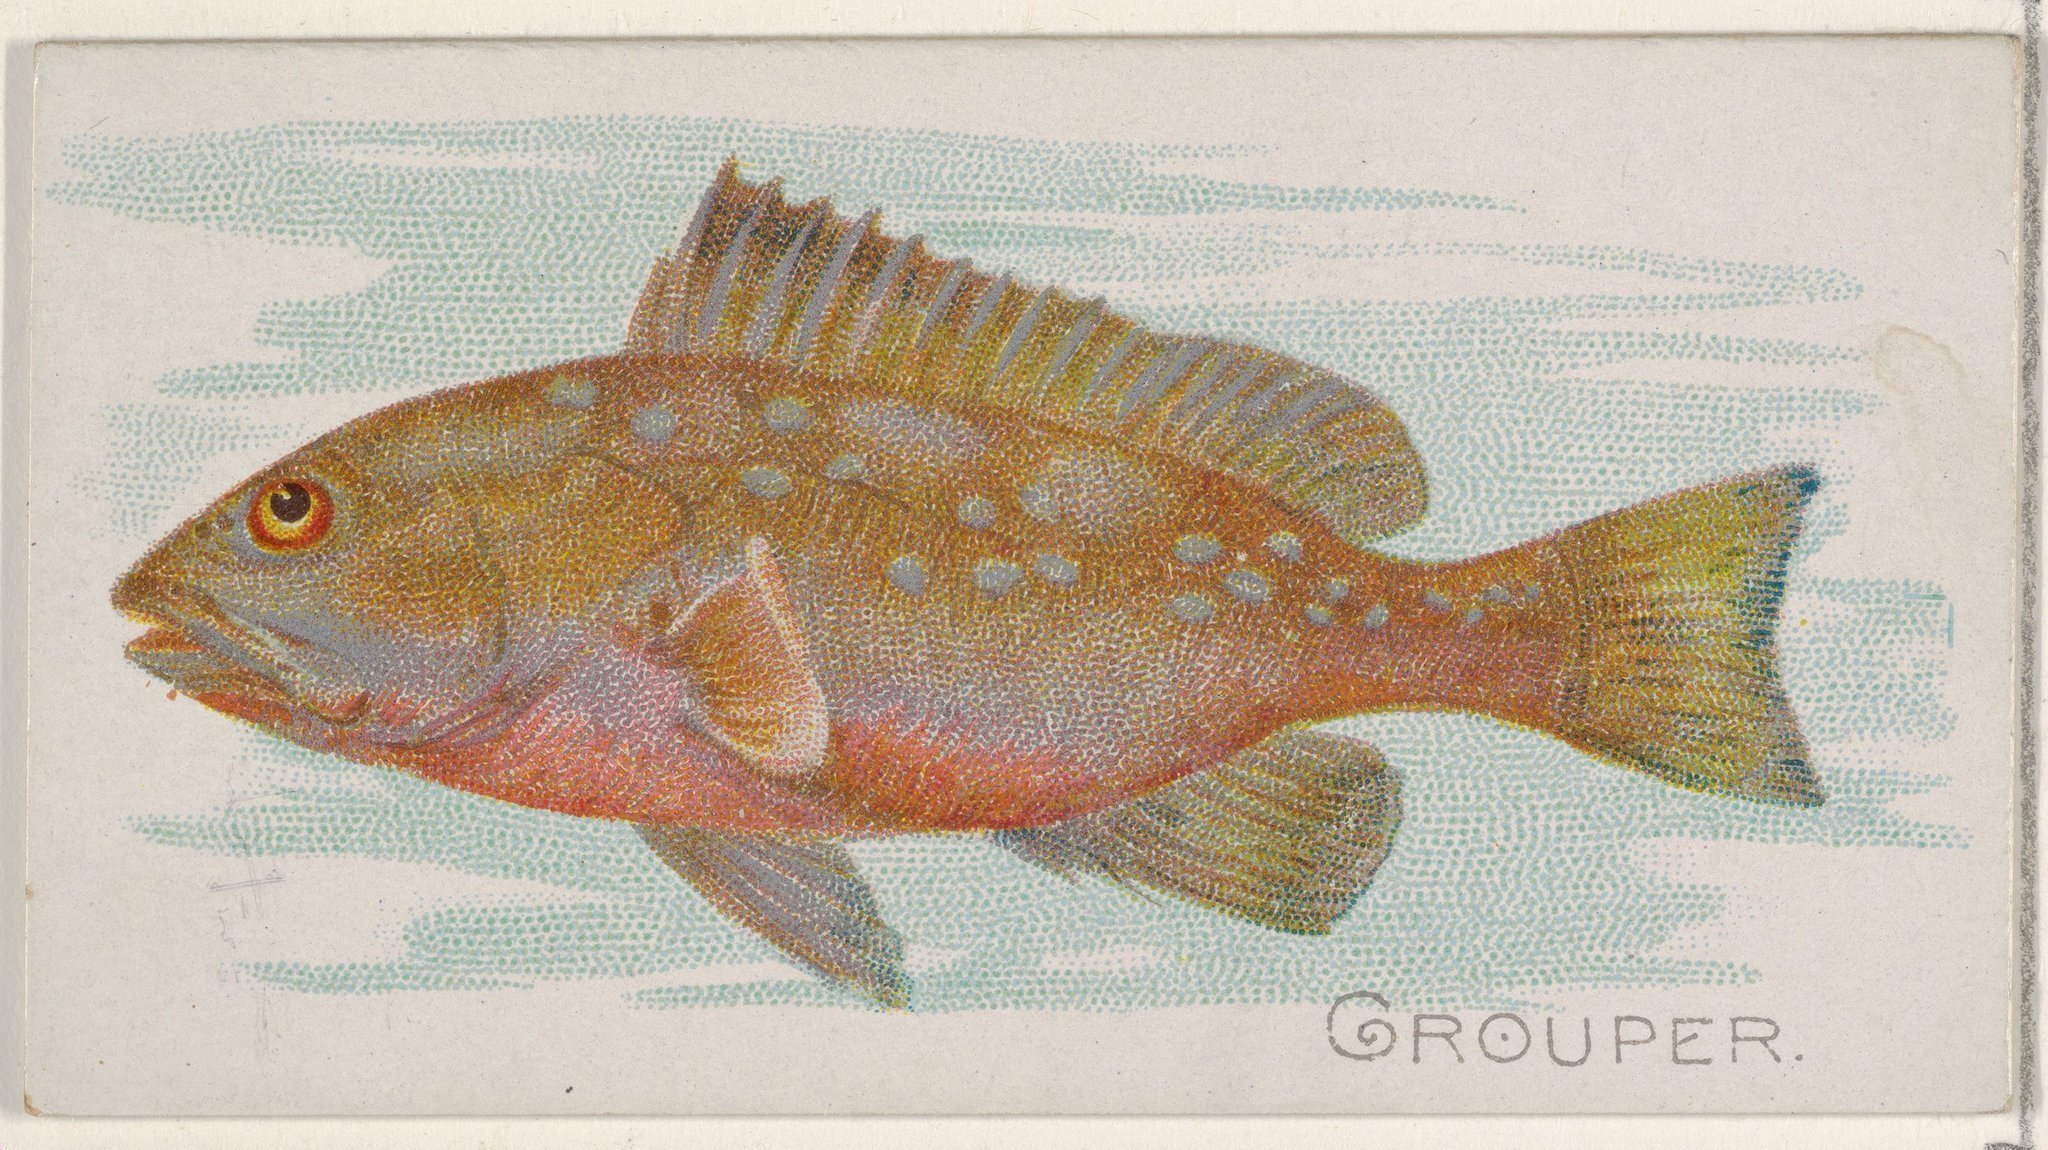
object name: print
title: Grouper, from the Fish from American Waters series (N8) for Allen & Ginter Cigarettes Brands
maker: allen & ginter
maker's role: publisher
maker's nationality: american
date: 1889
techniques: color lithograph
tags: fish